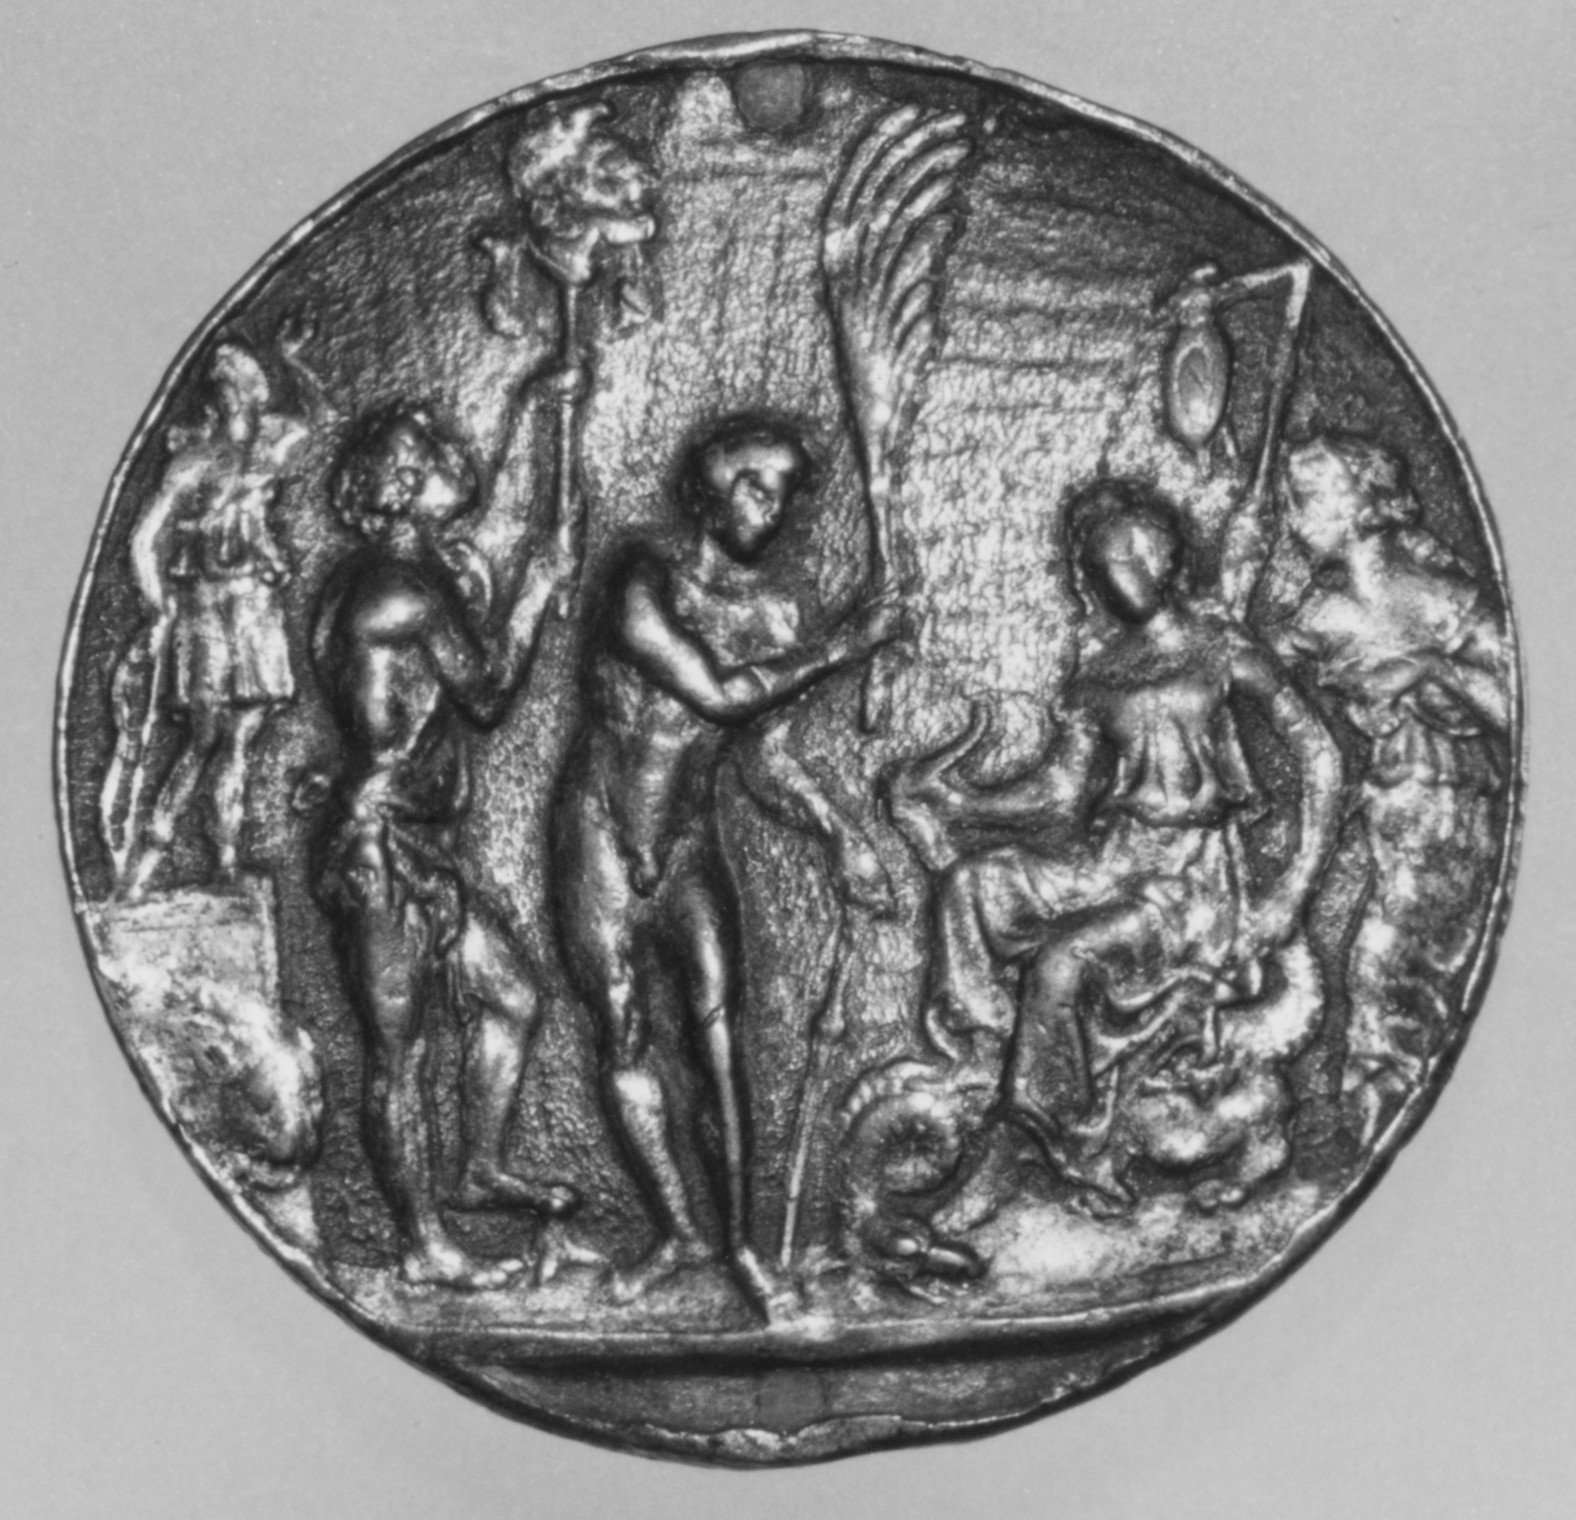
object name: plaquette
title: Allegorical scene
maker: master io. f.f.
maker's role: artist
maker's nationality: italian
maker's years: 1400-1550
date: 1501-1533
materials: bronze, gilt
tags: male nudes,women